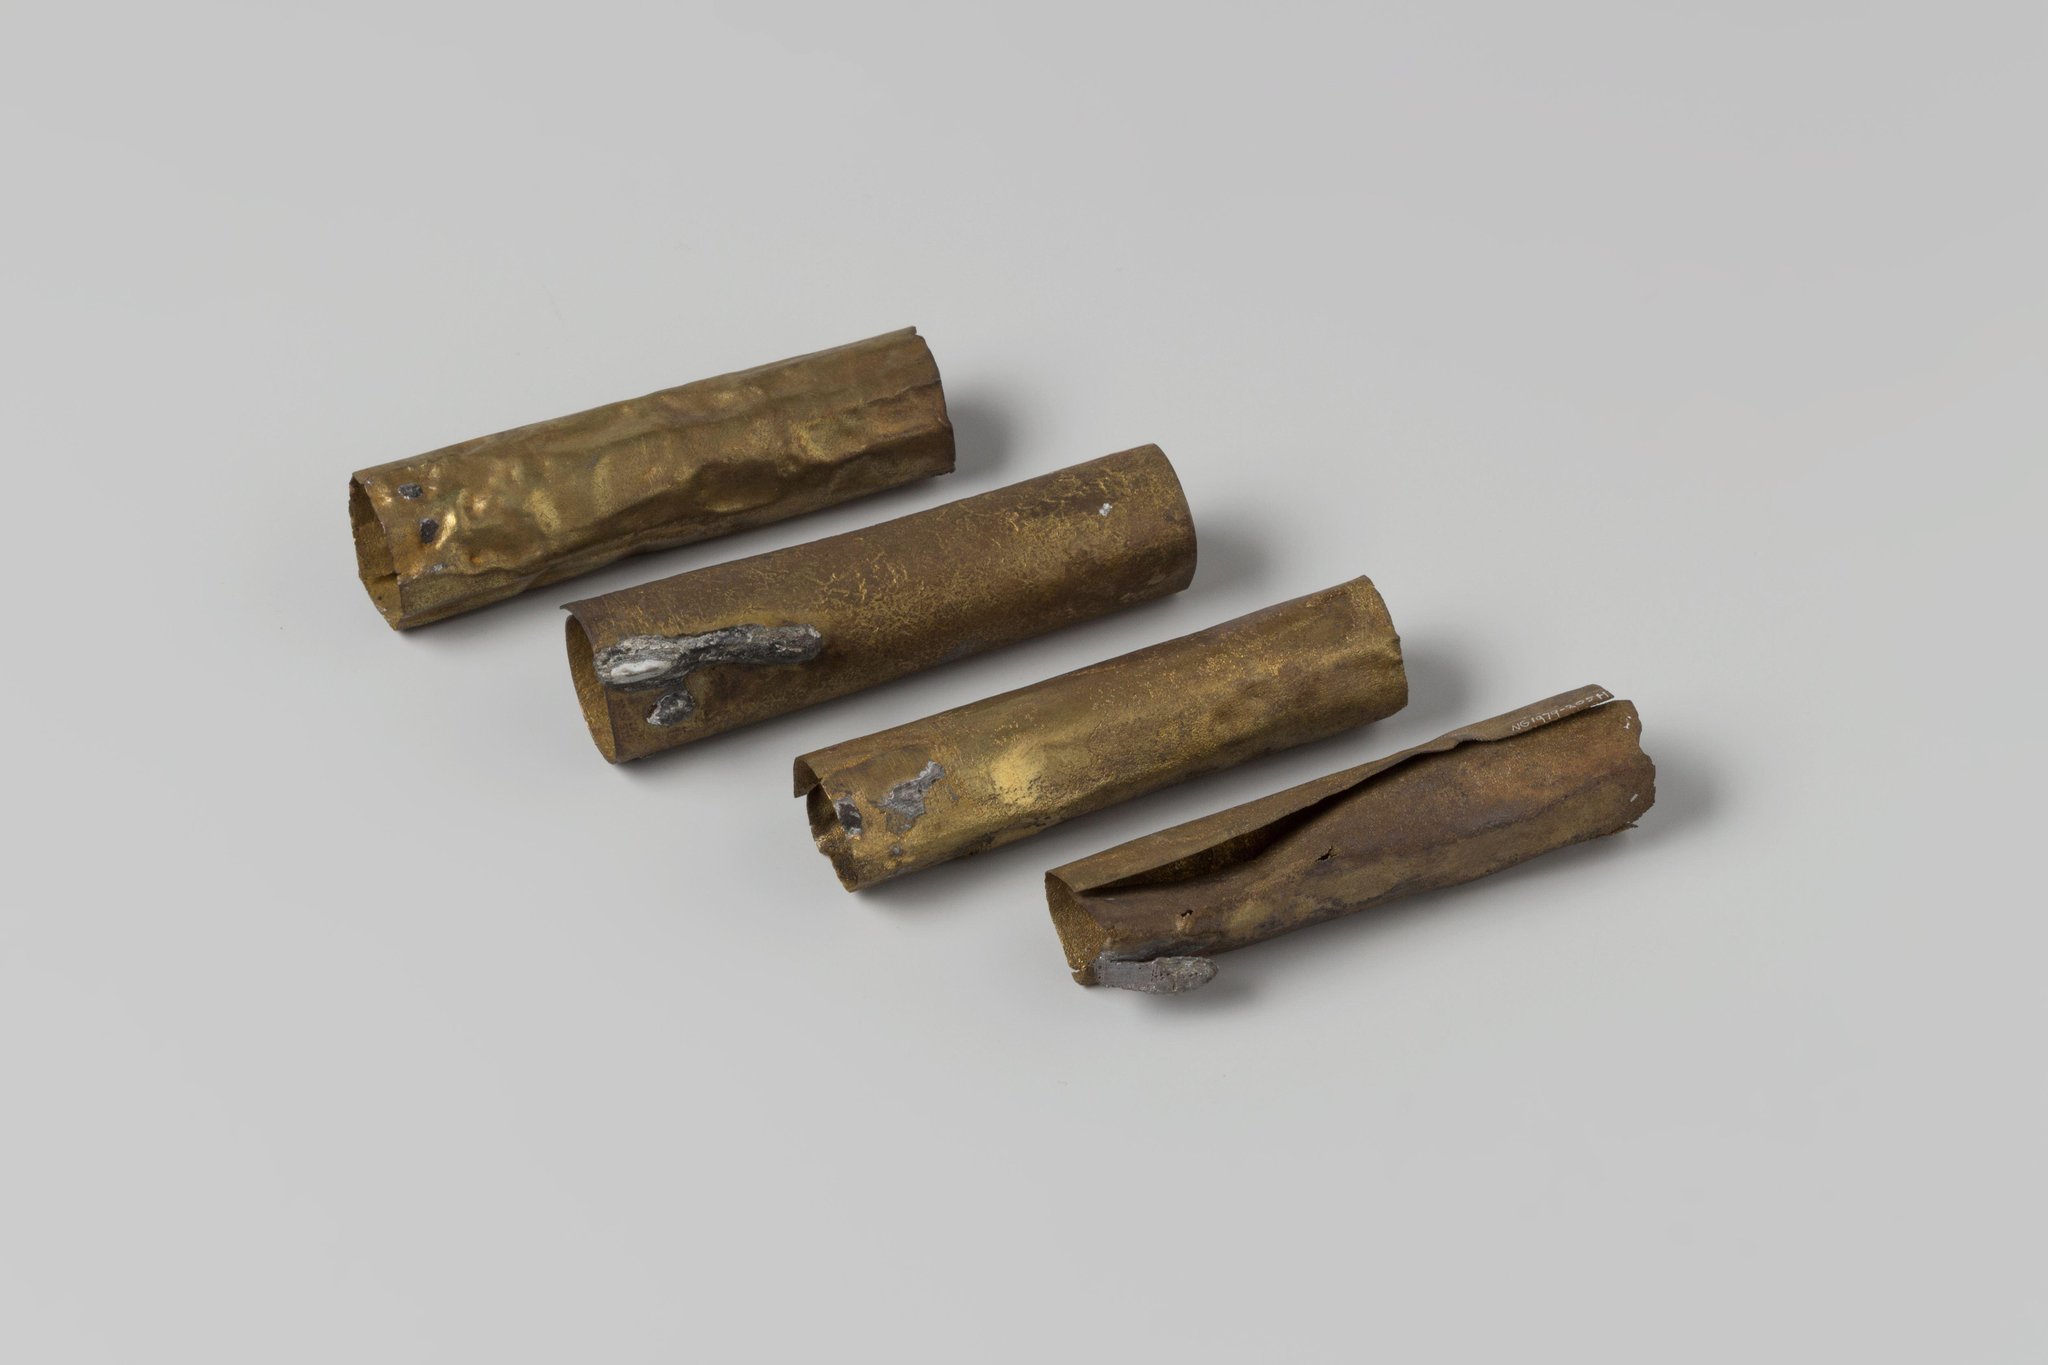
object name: cartridge shell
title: Cartridge tubes from the wreck of the Dutch East Indiaman Hollandia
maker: Anonymous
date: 1700-1743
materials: copper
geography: netherlands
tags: verenigde oostindische compagnie, hollandia (schip), annet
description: Cartridge case, tube; straight cylindrical tubes of rolled copper sheet, overlapping seam with at one end oblong drop-shaped piece of solder.